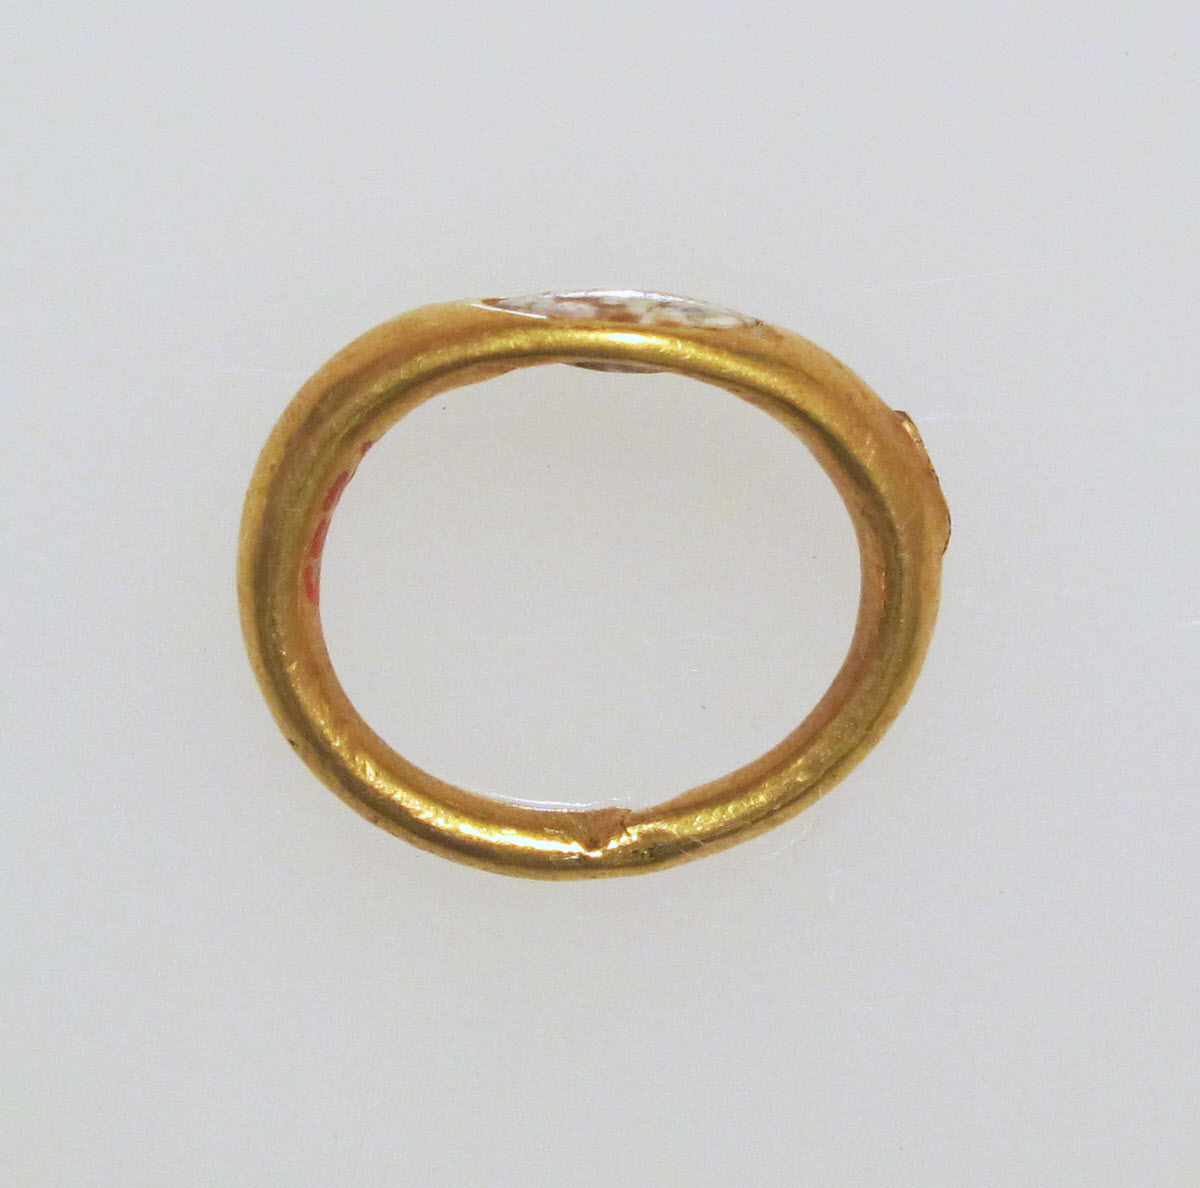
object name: ring with turquoise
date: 7000 BCE-330 CE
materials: gold